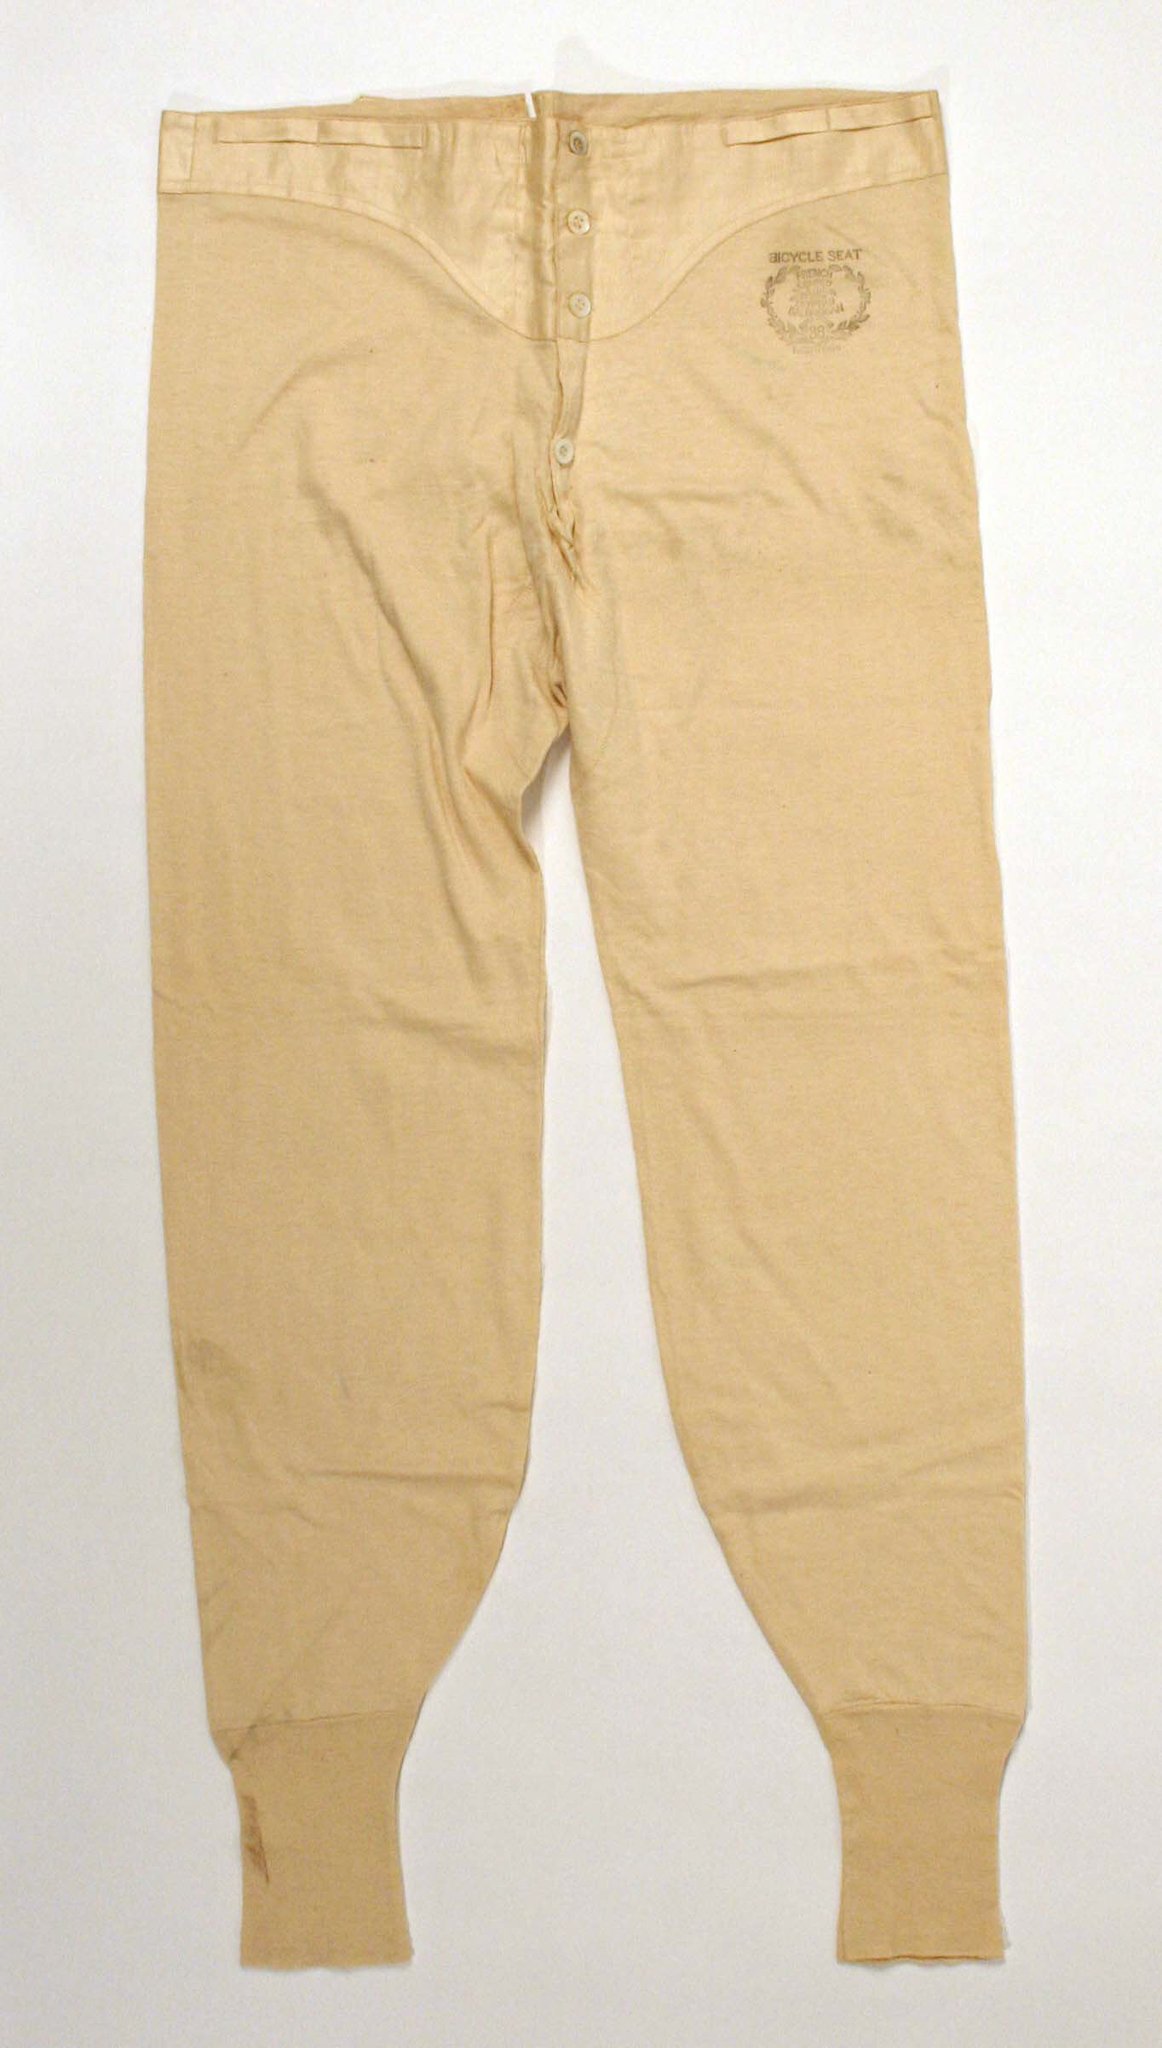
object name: underwear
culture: american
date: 1890-1899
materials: cotton